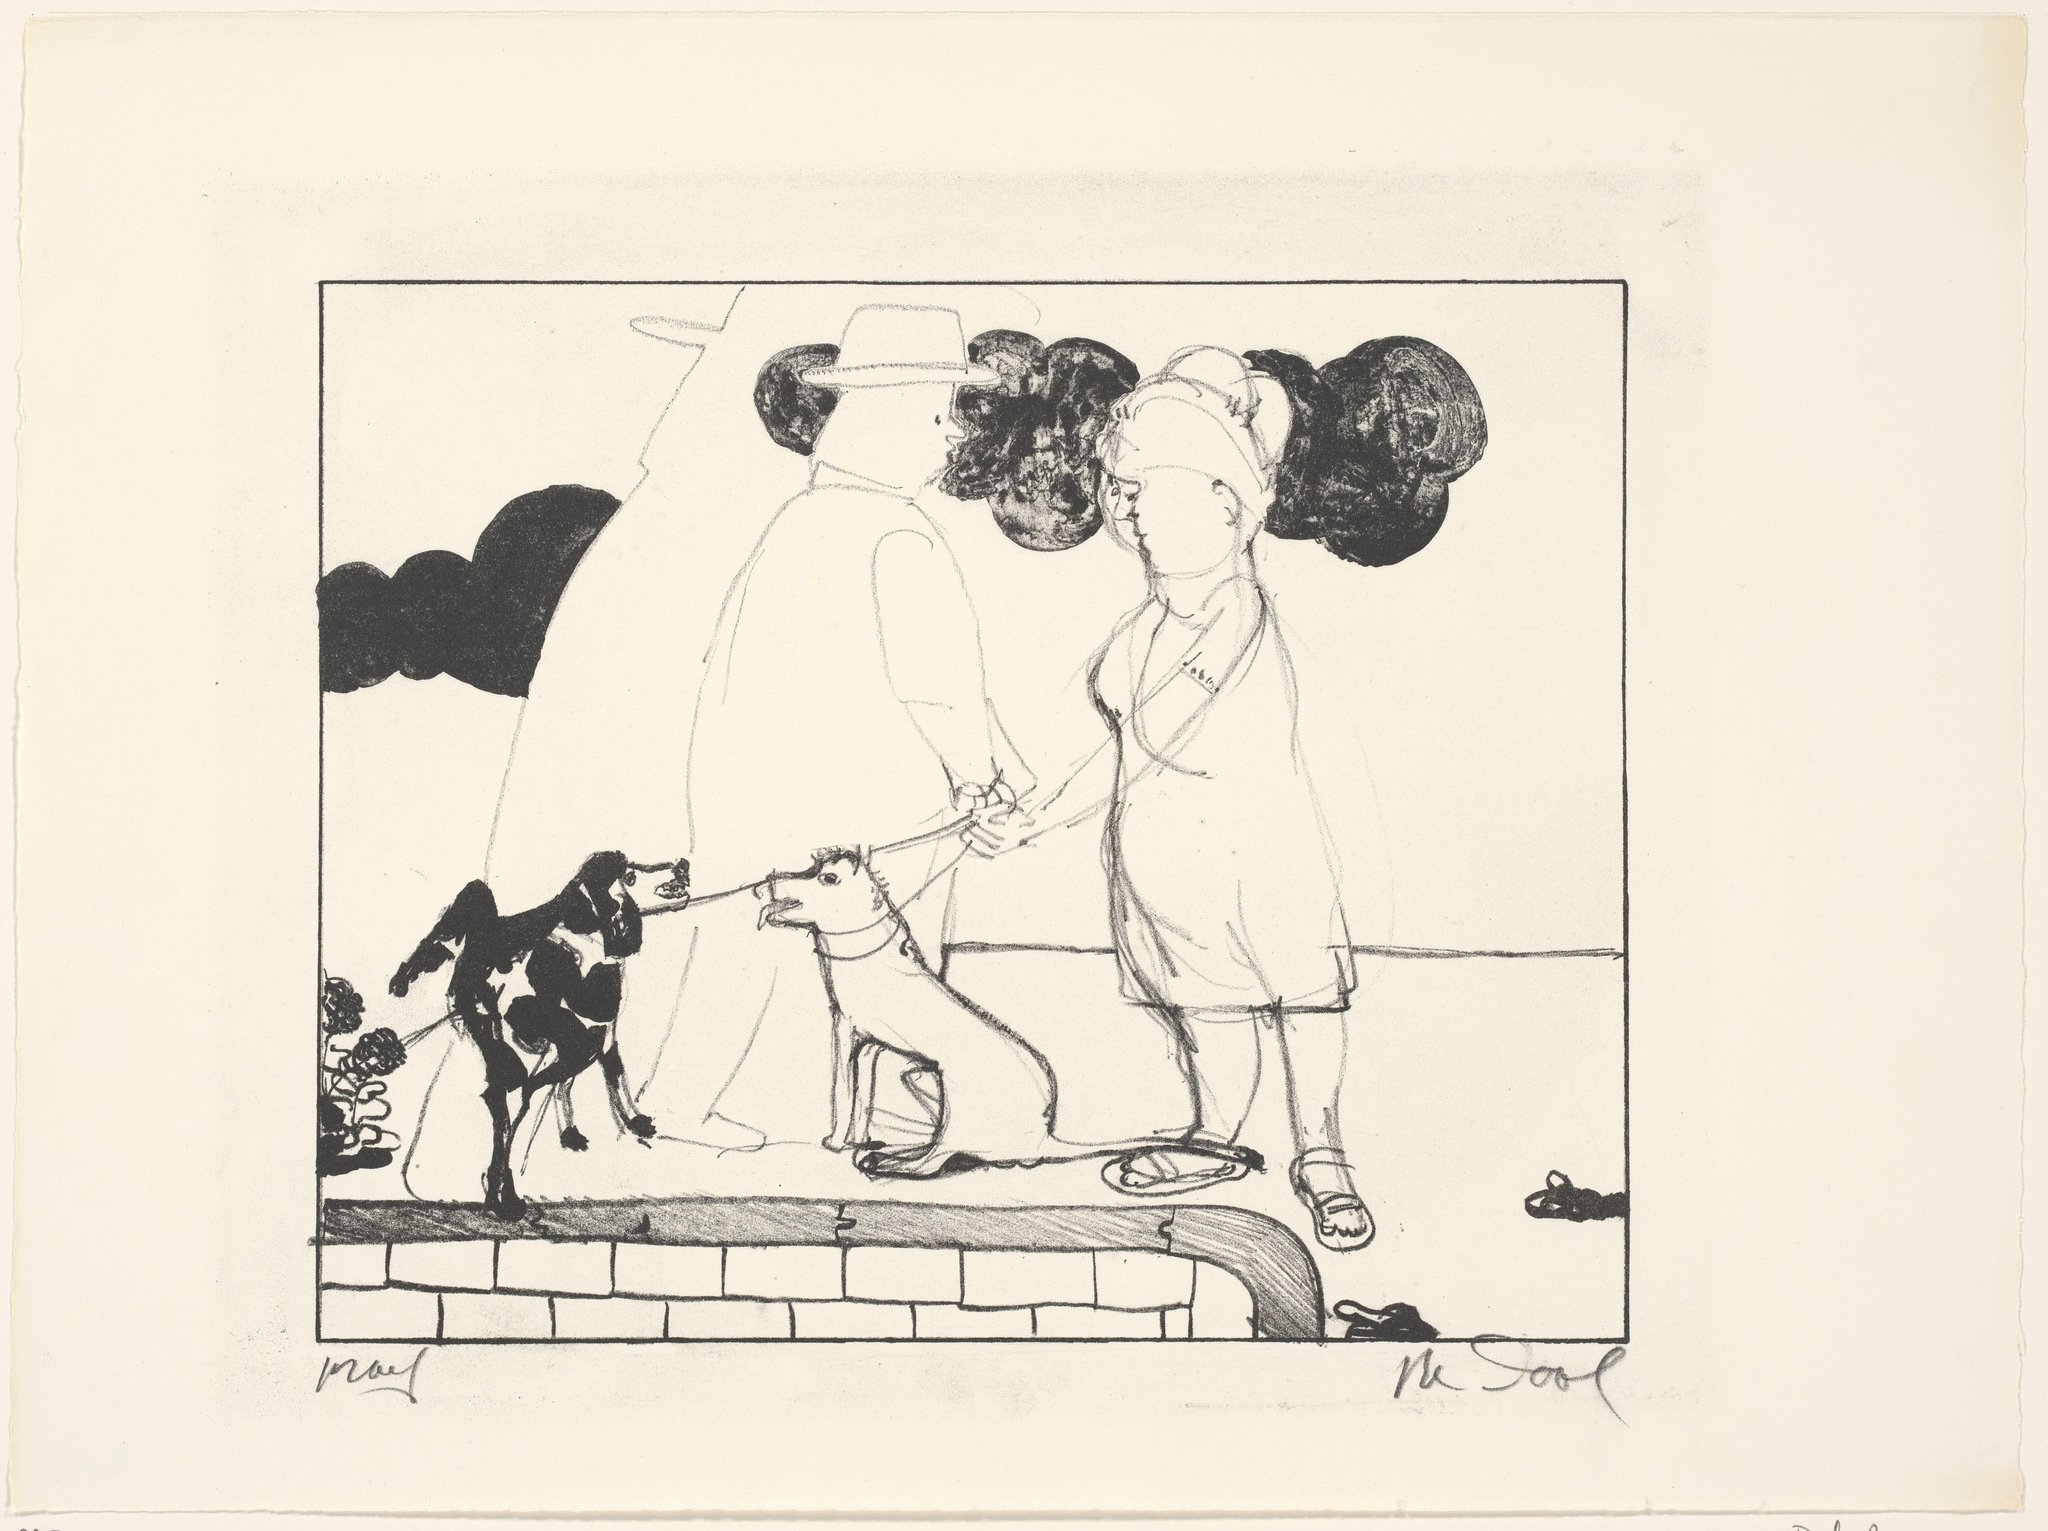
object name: print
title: Ontmoeting (van bazen en honden)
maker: rein dool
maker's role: draughtsman, painter, print maker, sculptor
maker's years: 1933-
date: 1970-1980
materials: paper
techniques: lithograph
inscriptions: signature